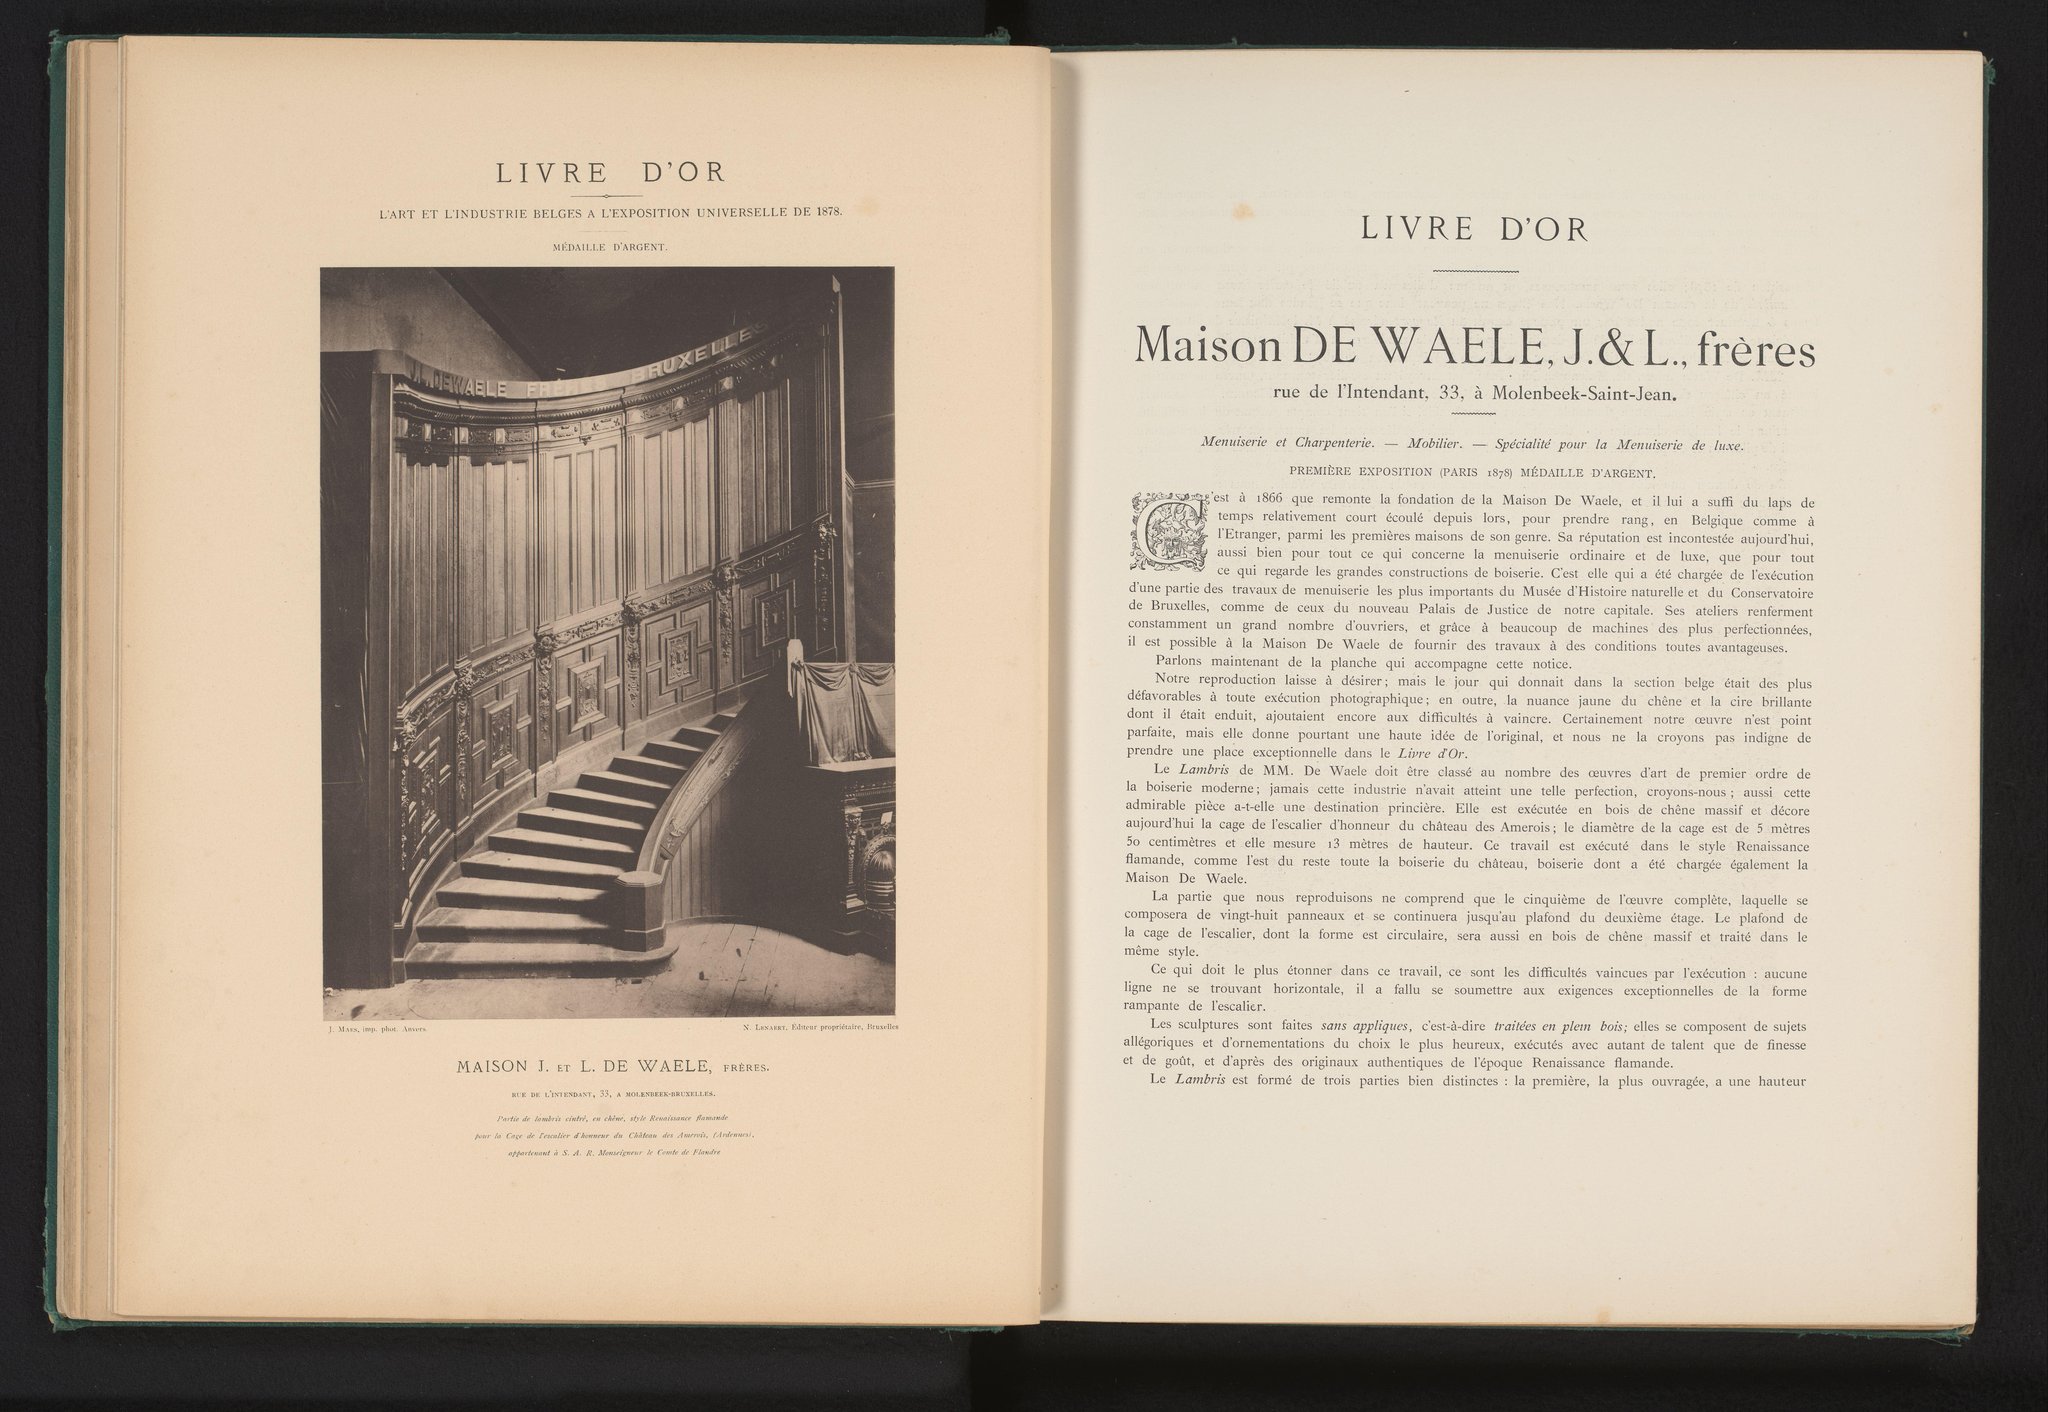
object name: page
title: Maison J. et L. de Waele, frères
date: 1874-1879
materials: paper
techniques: photograph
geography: antwerp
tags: panelling, staircase, sculpture (+ relief ~ sculpture)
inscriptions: inscription: ‘Livre d'or/ L'art et l'industrie Belges a l'exposition universelle de 1878.’, inscription: ‘Rue de l'Intendant, 33, a Molenbeek-Bruxelles’